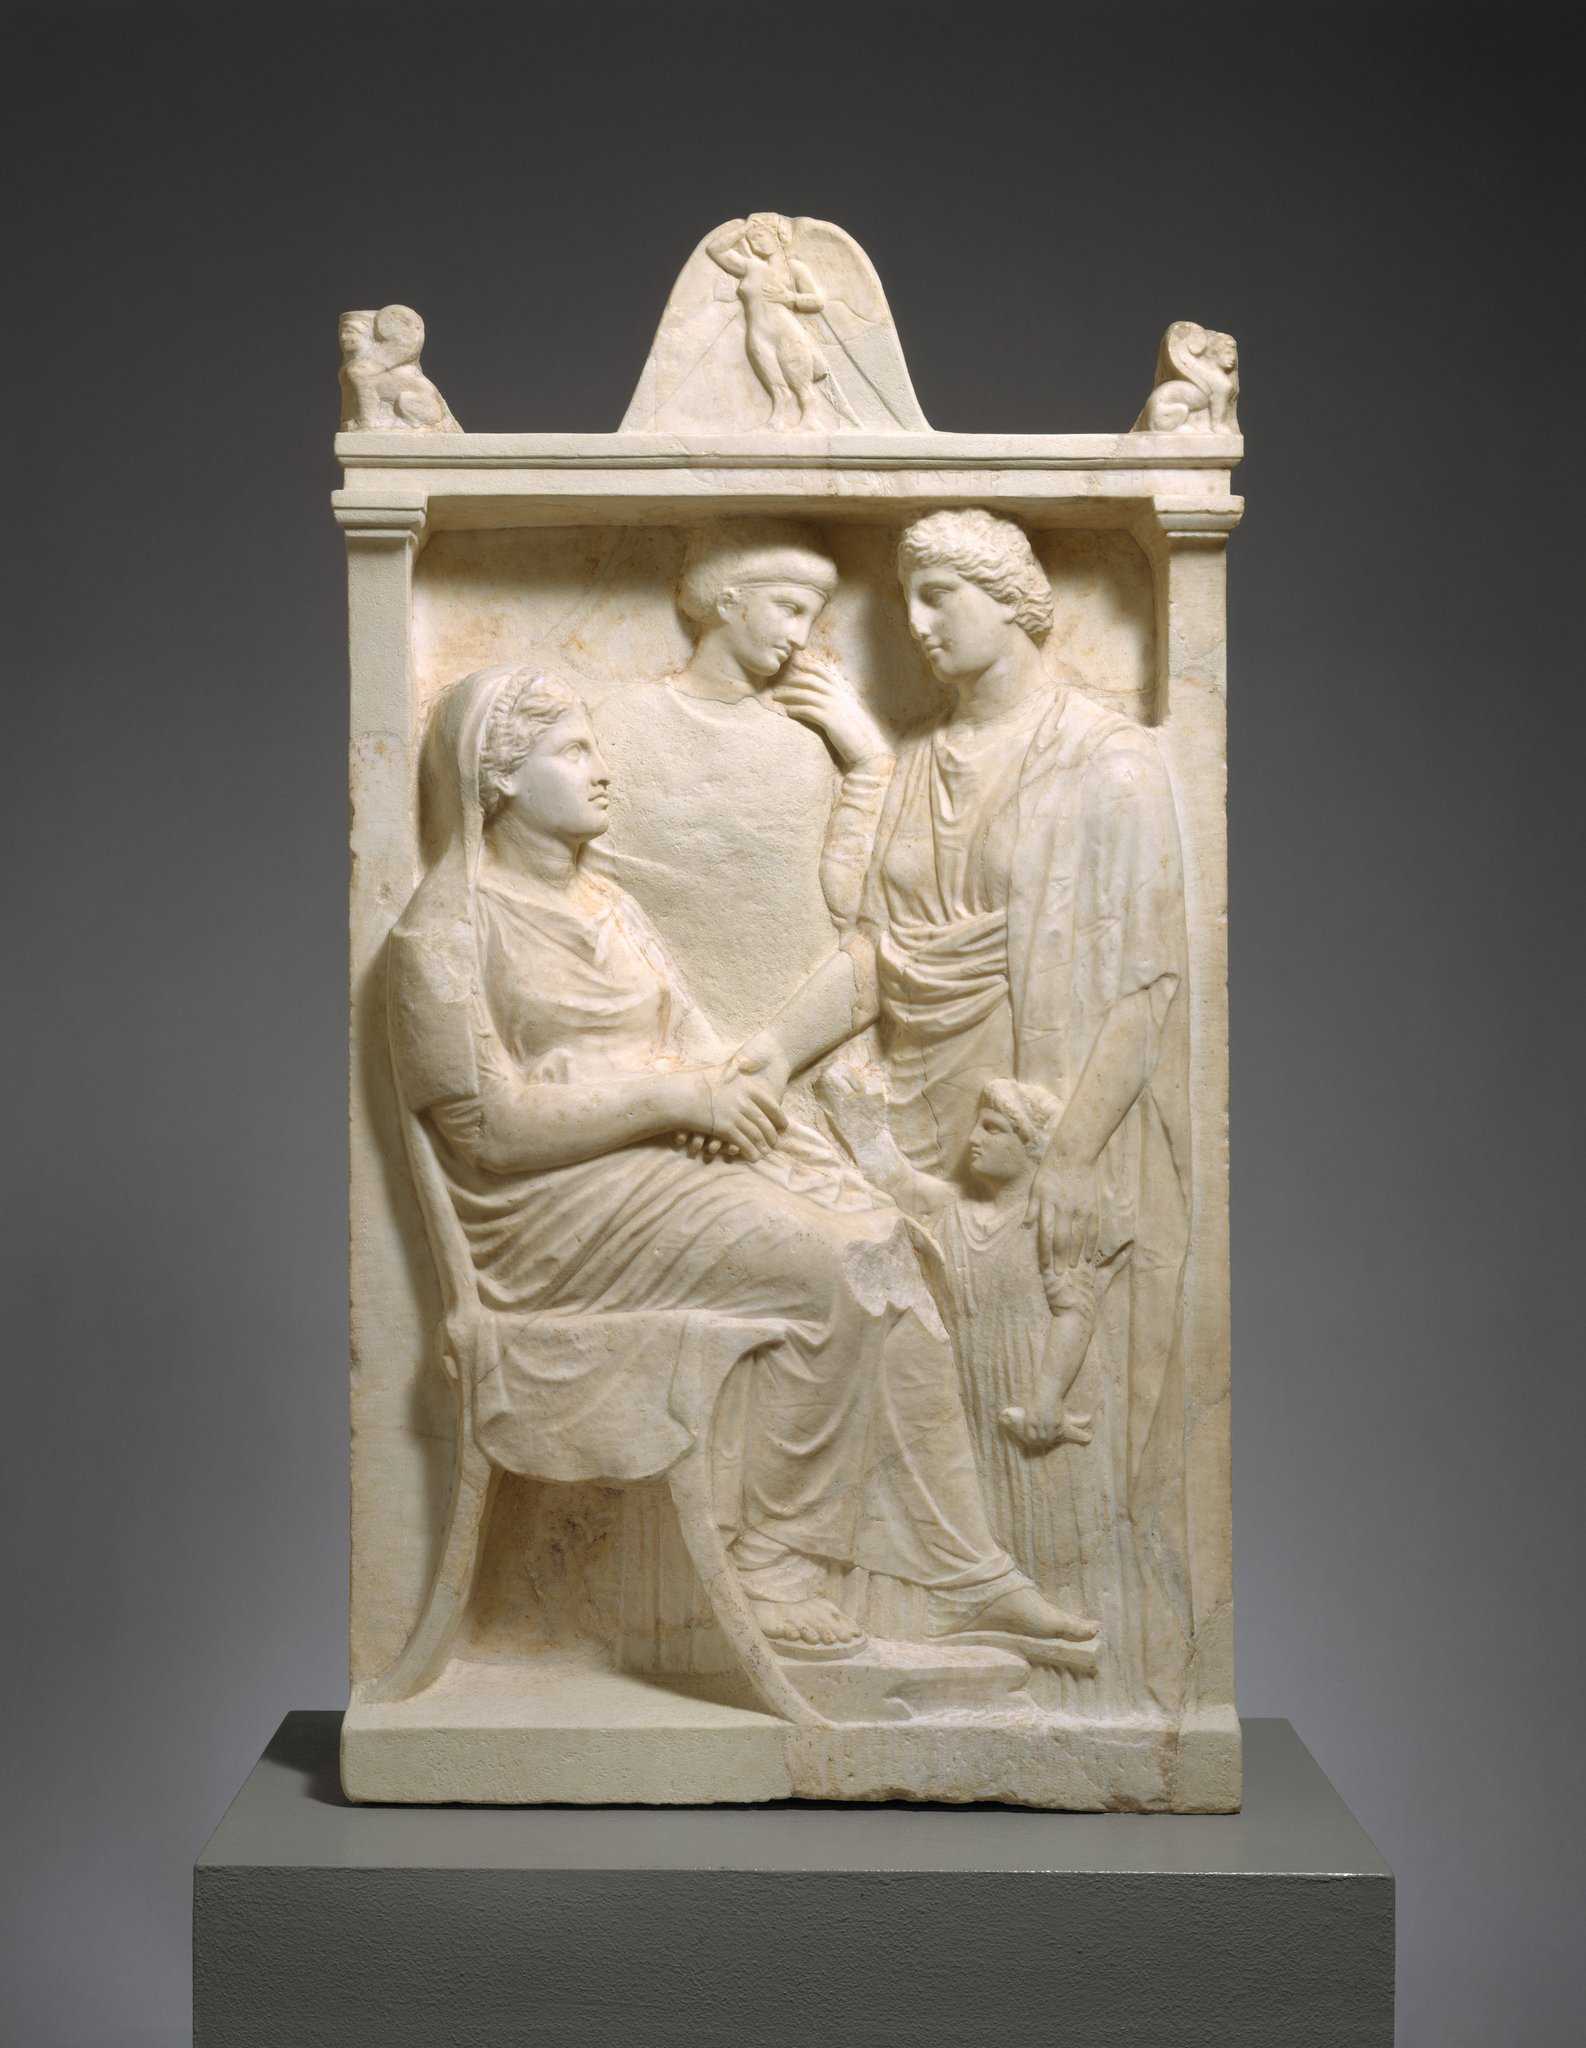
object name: grave stele of a woman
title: Marble stele (grave marker) of a woman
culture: greek, attic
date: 375-350 BCE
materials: marble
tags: men,women